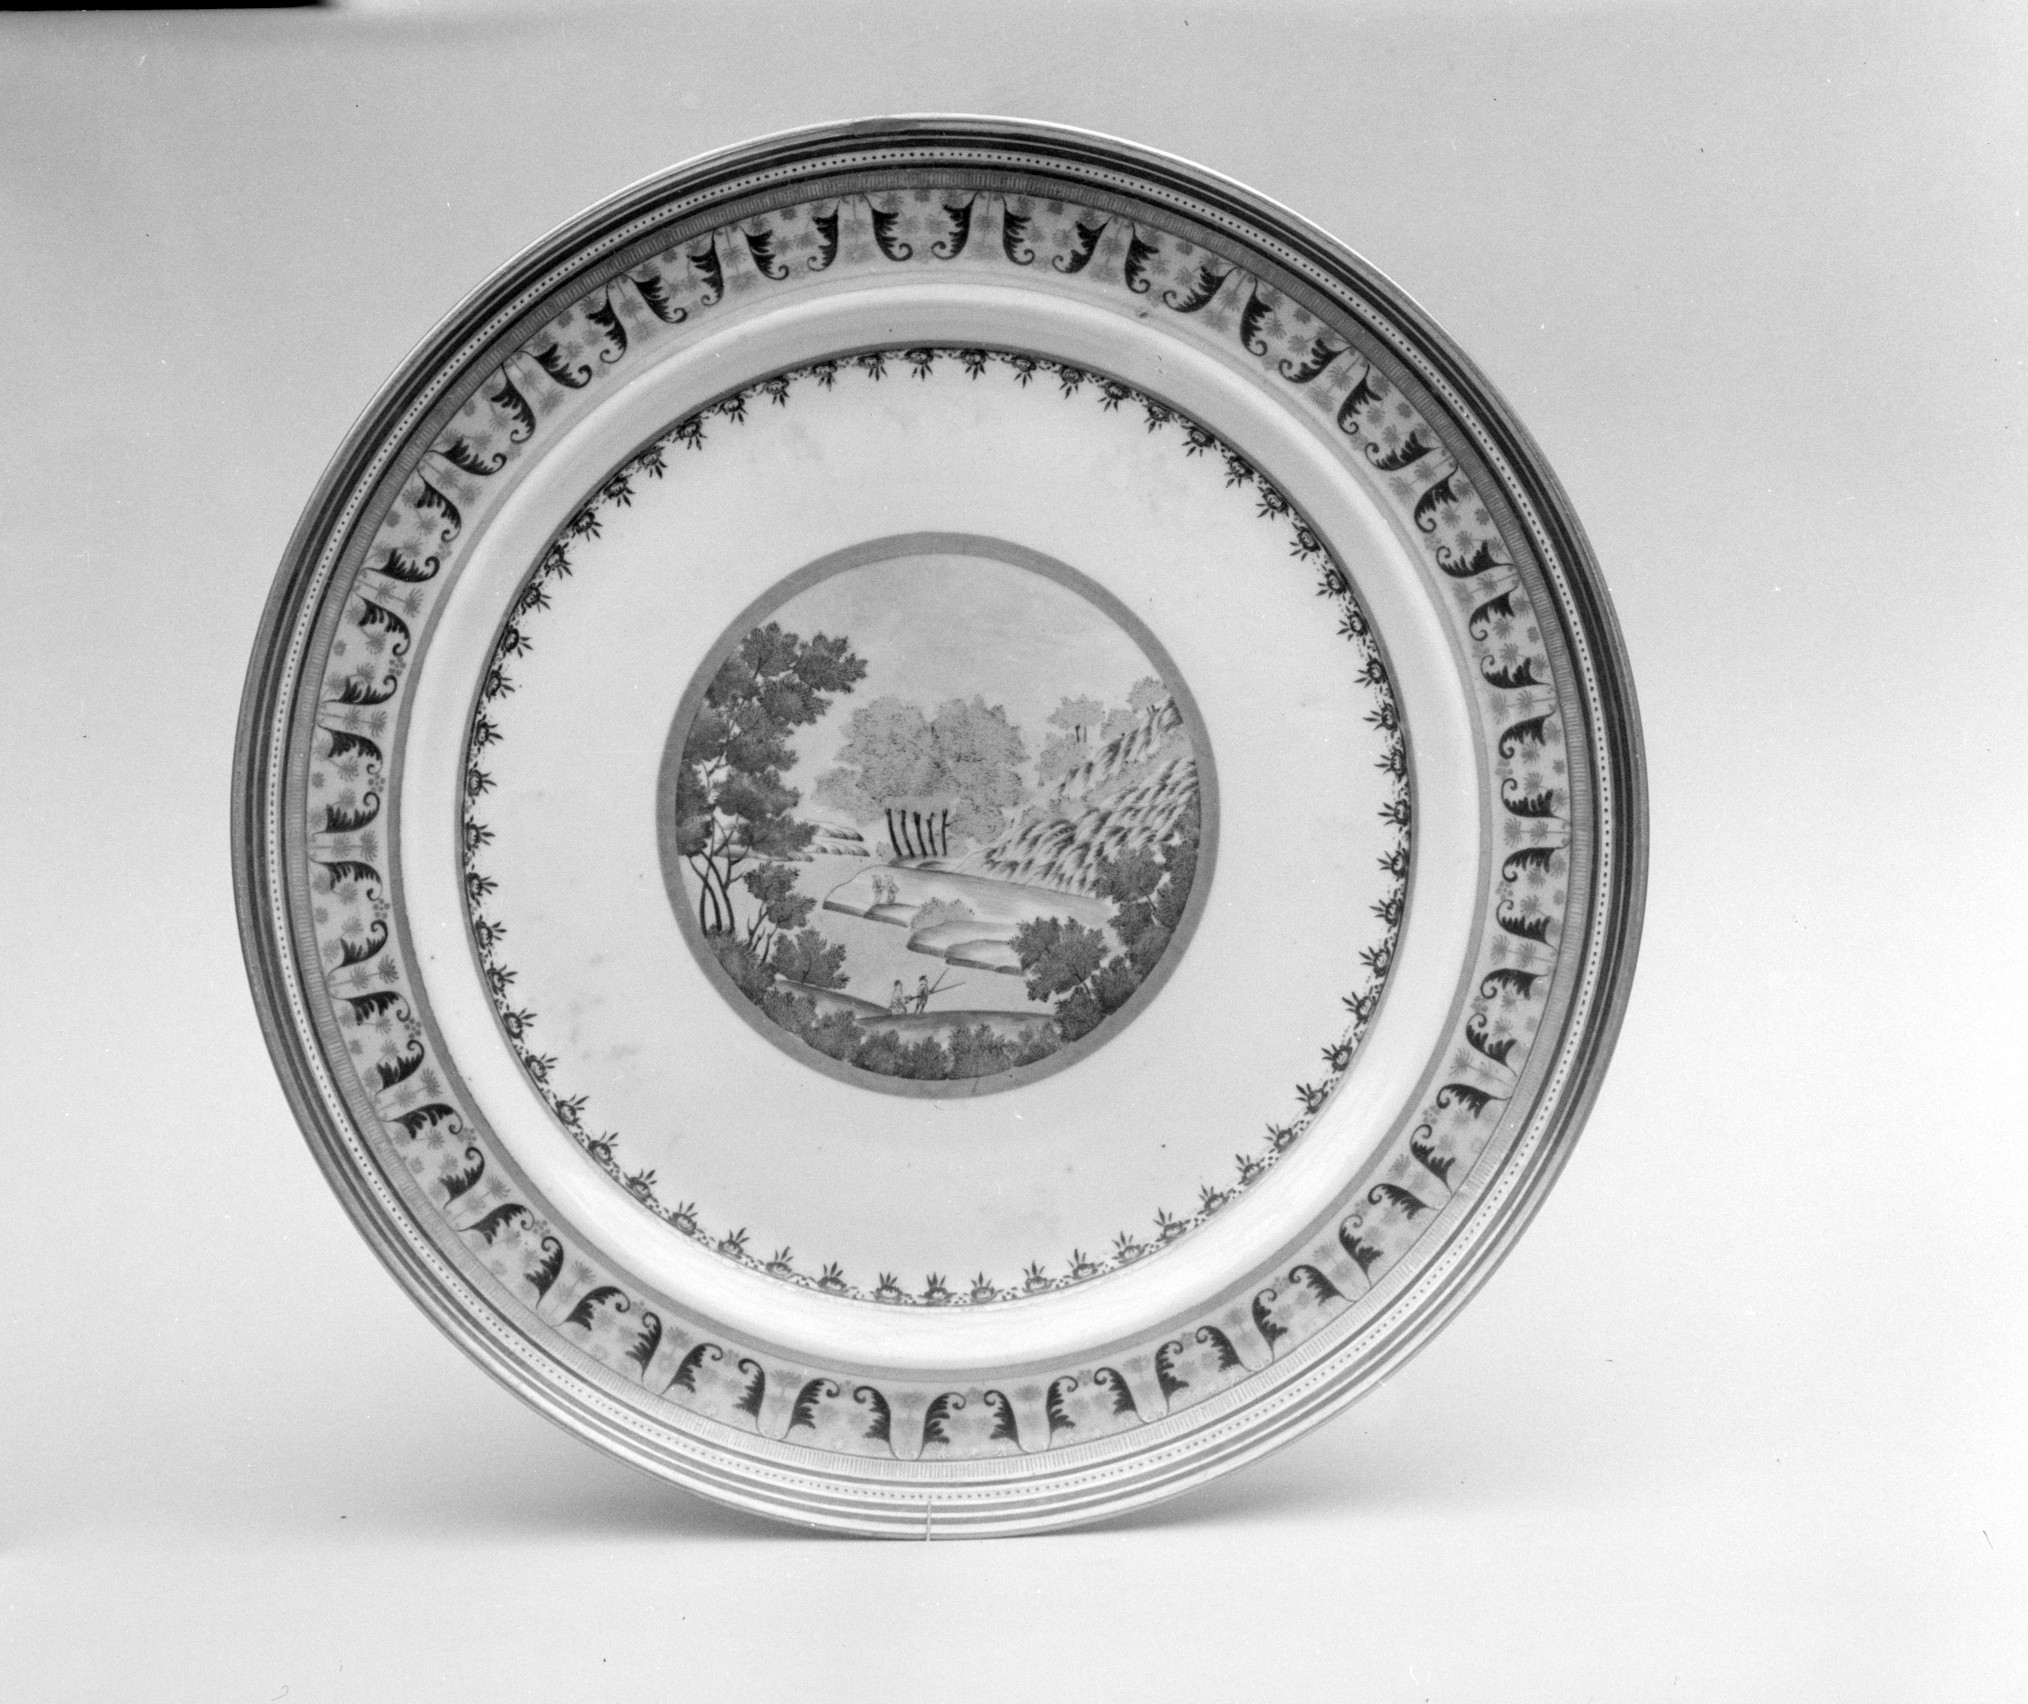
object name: plate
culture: chinese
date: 1800-1830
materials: porcelain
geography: china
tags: landscapes